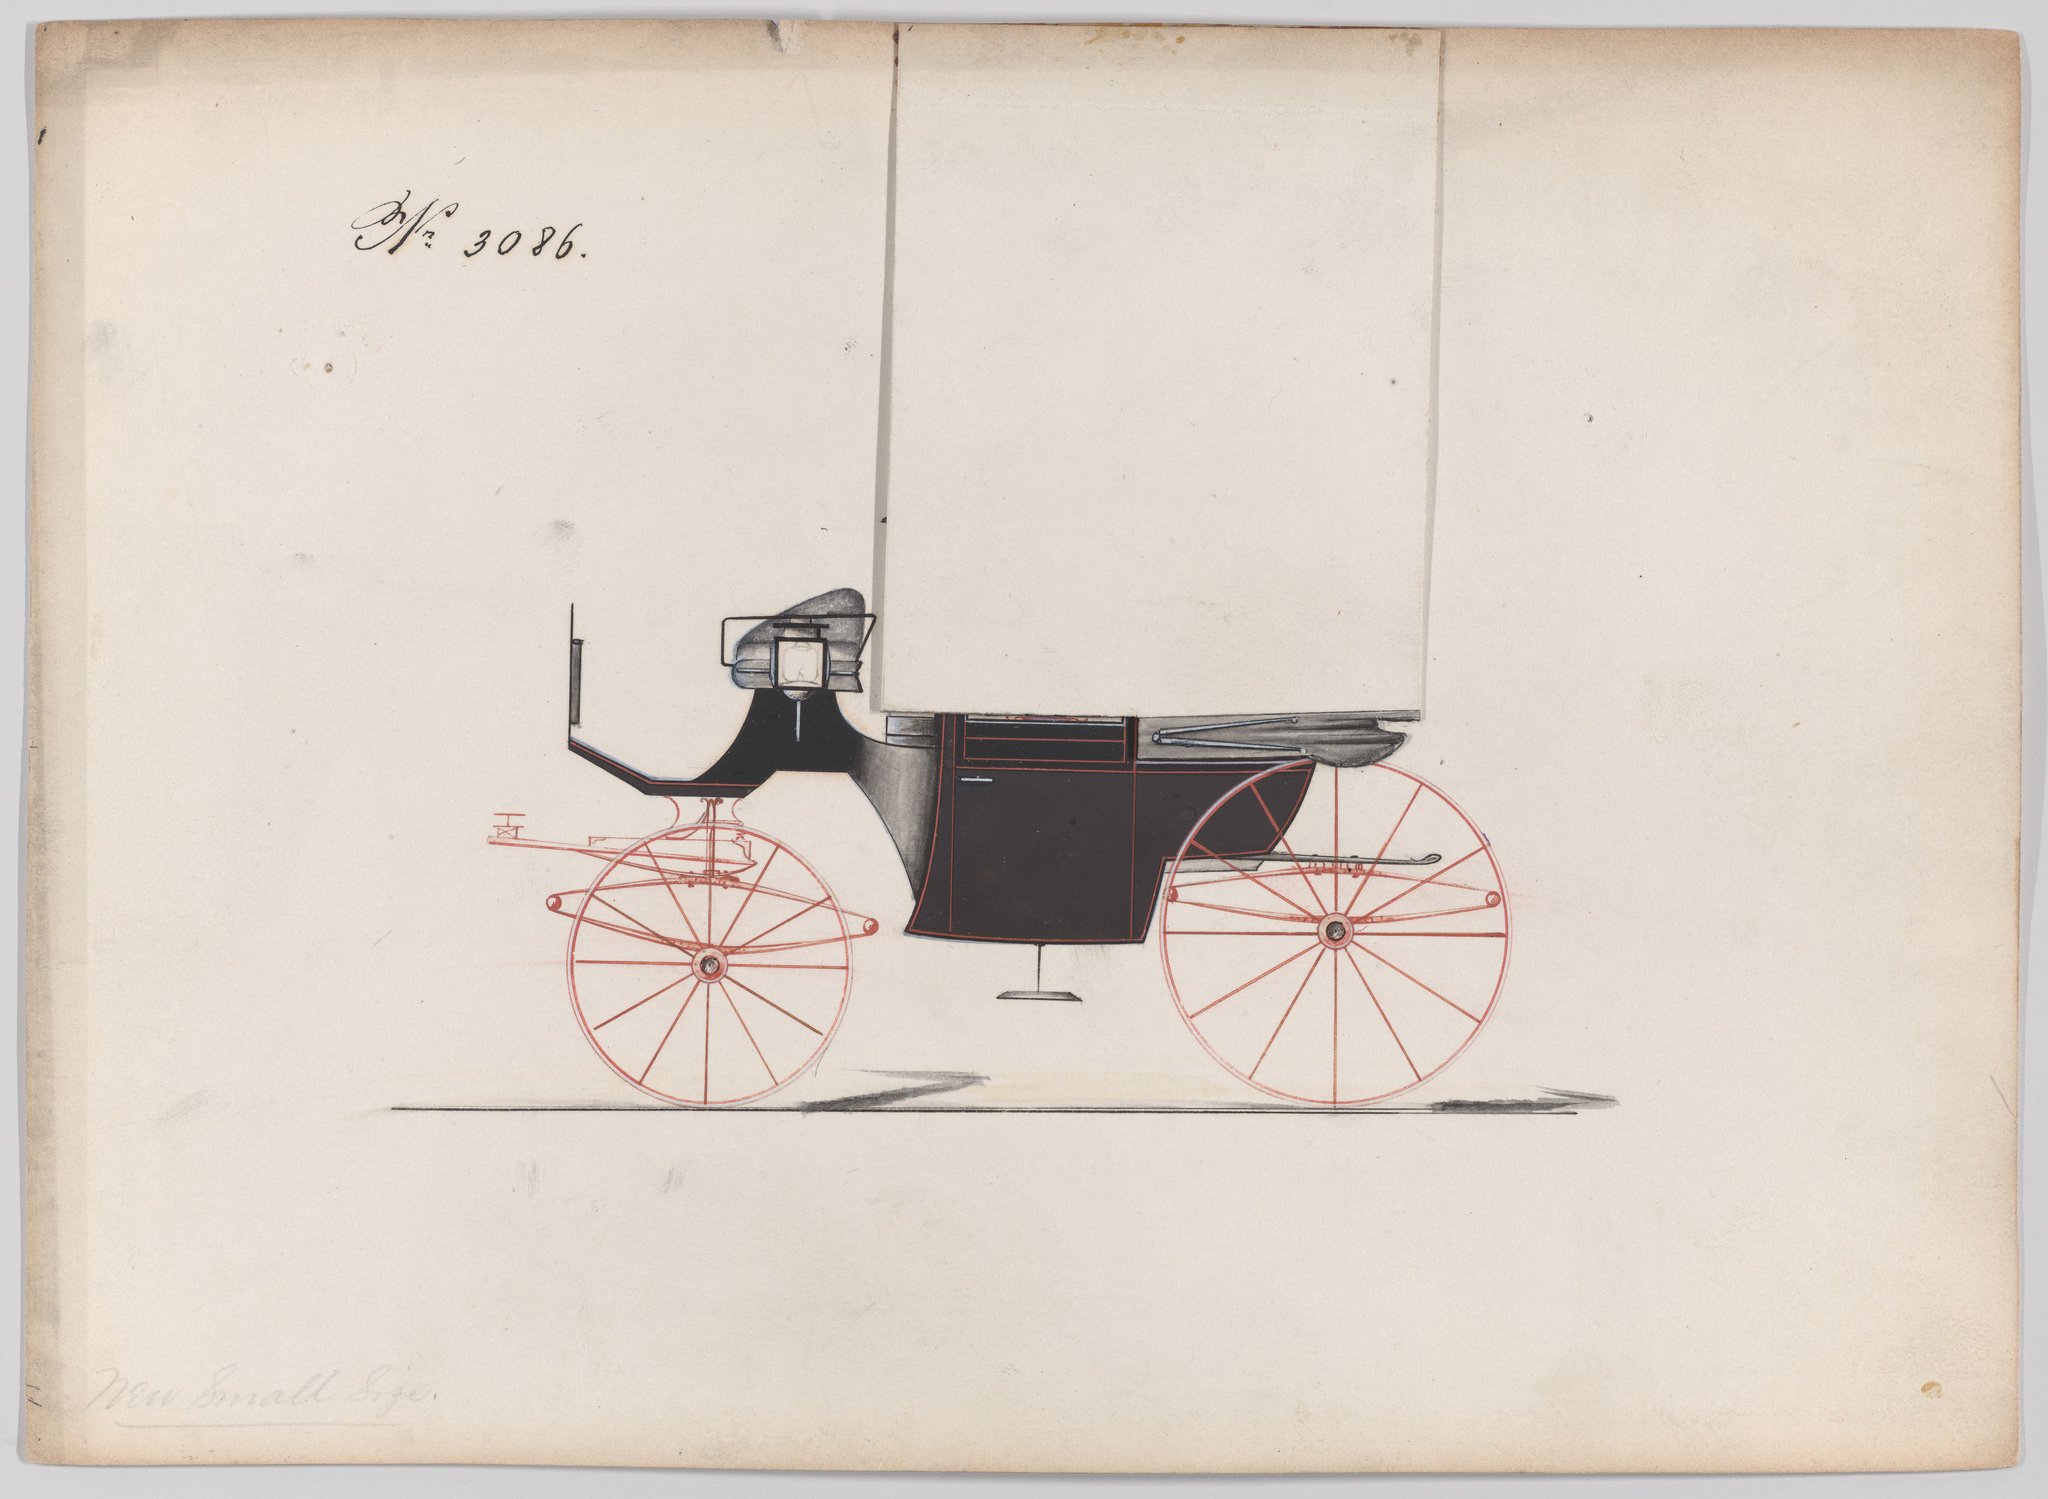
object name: drawing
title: Design for Landaulet, no. 3086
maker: brewster & co.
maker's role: manufacturer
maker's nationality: american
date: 1875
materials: gouache, ink, watercolor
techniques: pen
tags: carriages